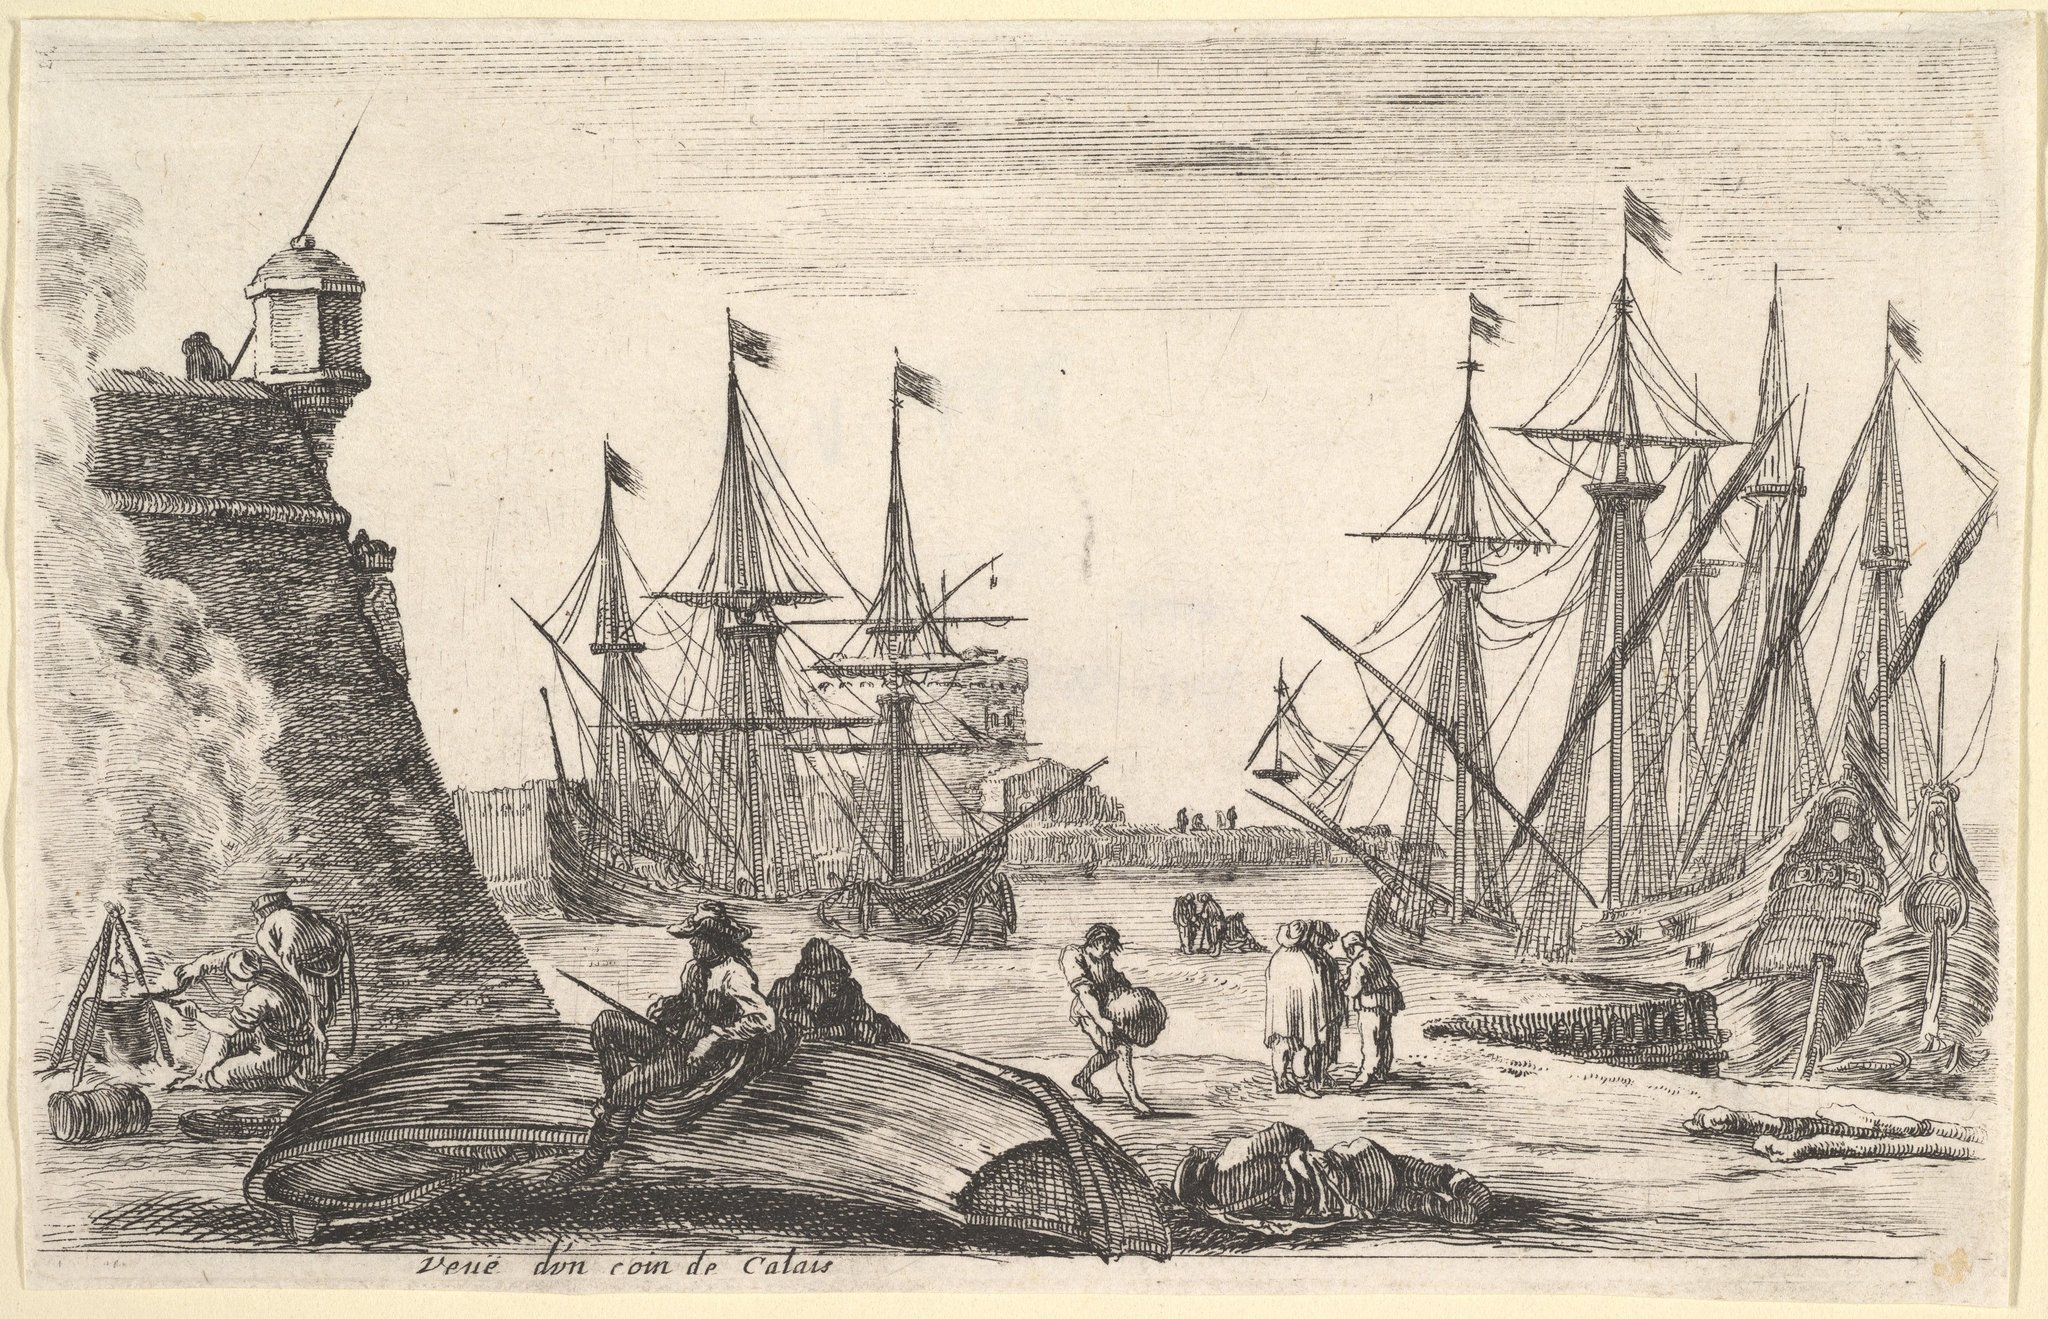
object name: print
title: View of a part of Calais (Veue d'un coin de Calais), from "Views of seaports" (Vues de ports de mar)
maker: stefano della bella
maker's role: artist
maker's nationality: italian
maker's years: 1610-1664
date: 1647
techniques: etching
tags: men,seas,working,boats,ships